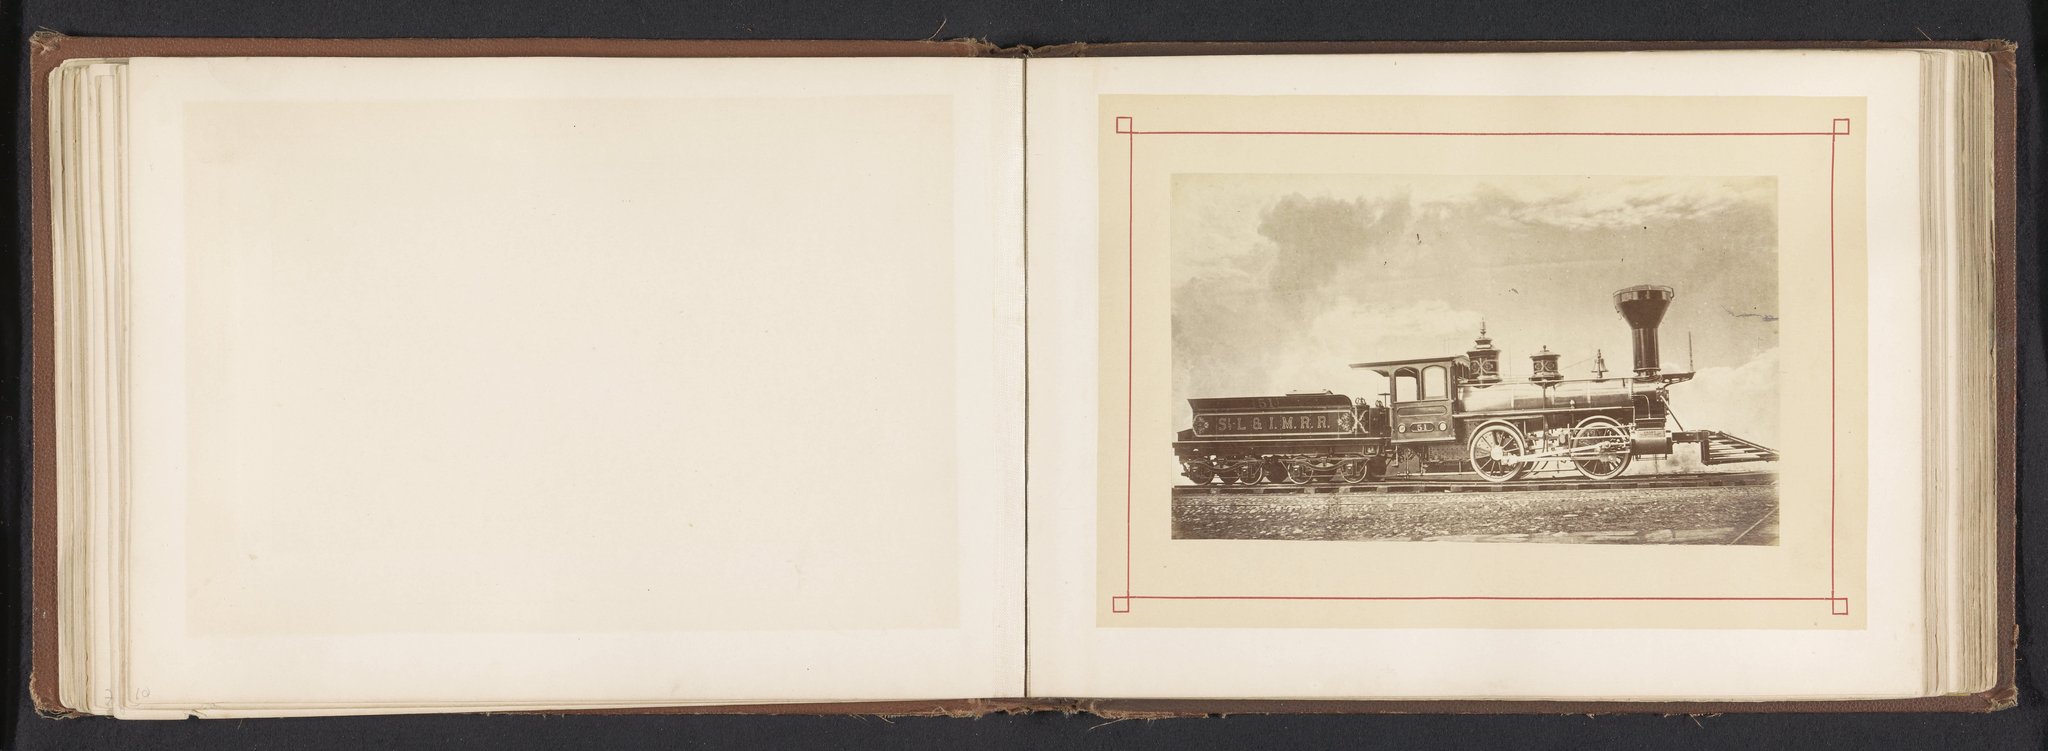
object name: photograph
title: Stoomlocomotief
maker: george gardner rockwood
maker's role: fotograaf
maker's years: 1832-1911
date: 1861-1871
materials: photographic support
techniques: albumen print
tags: steam locomotive